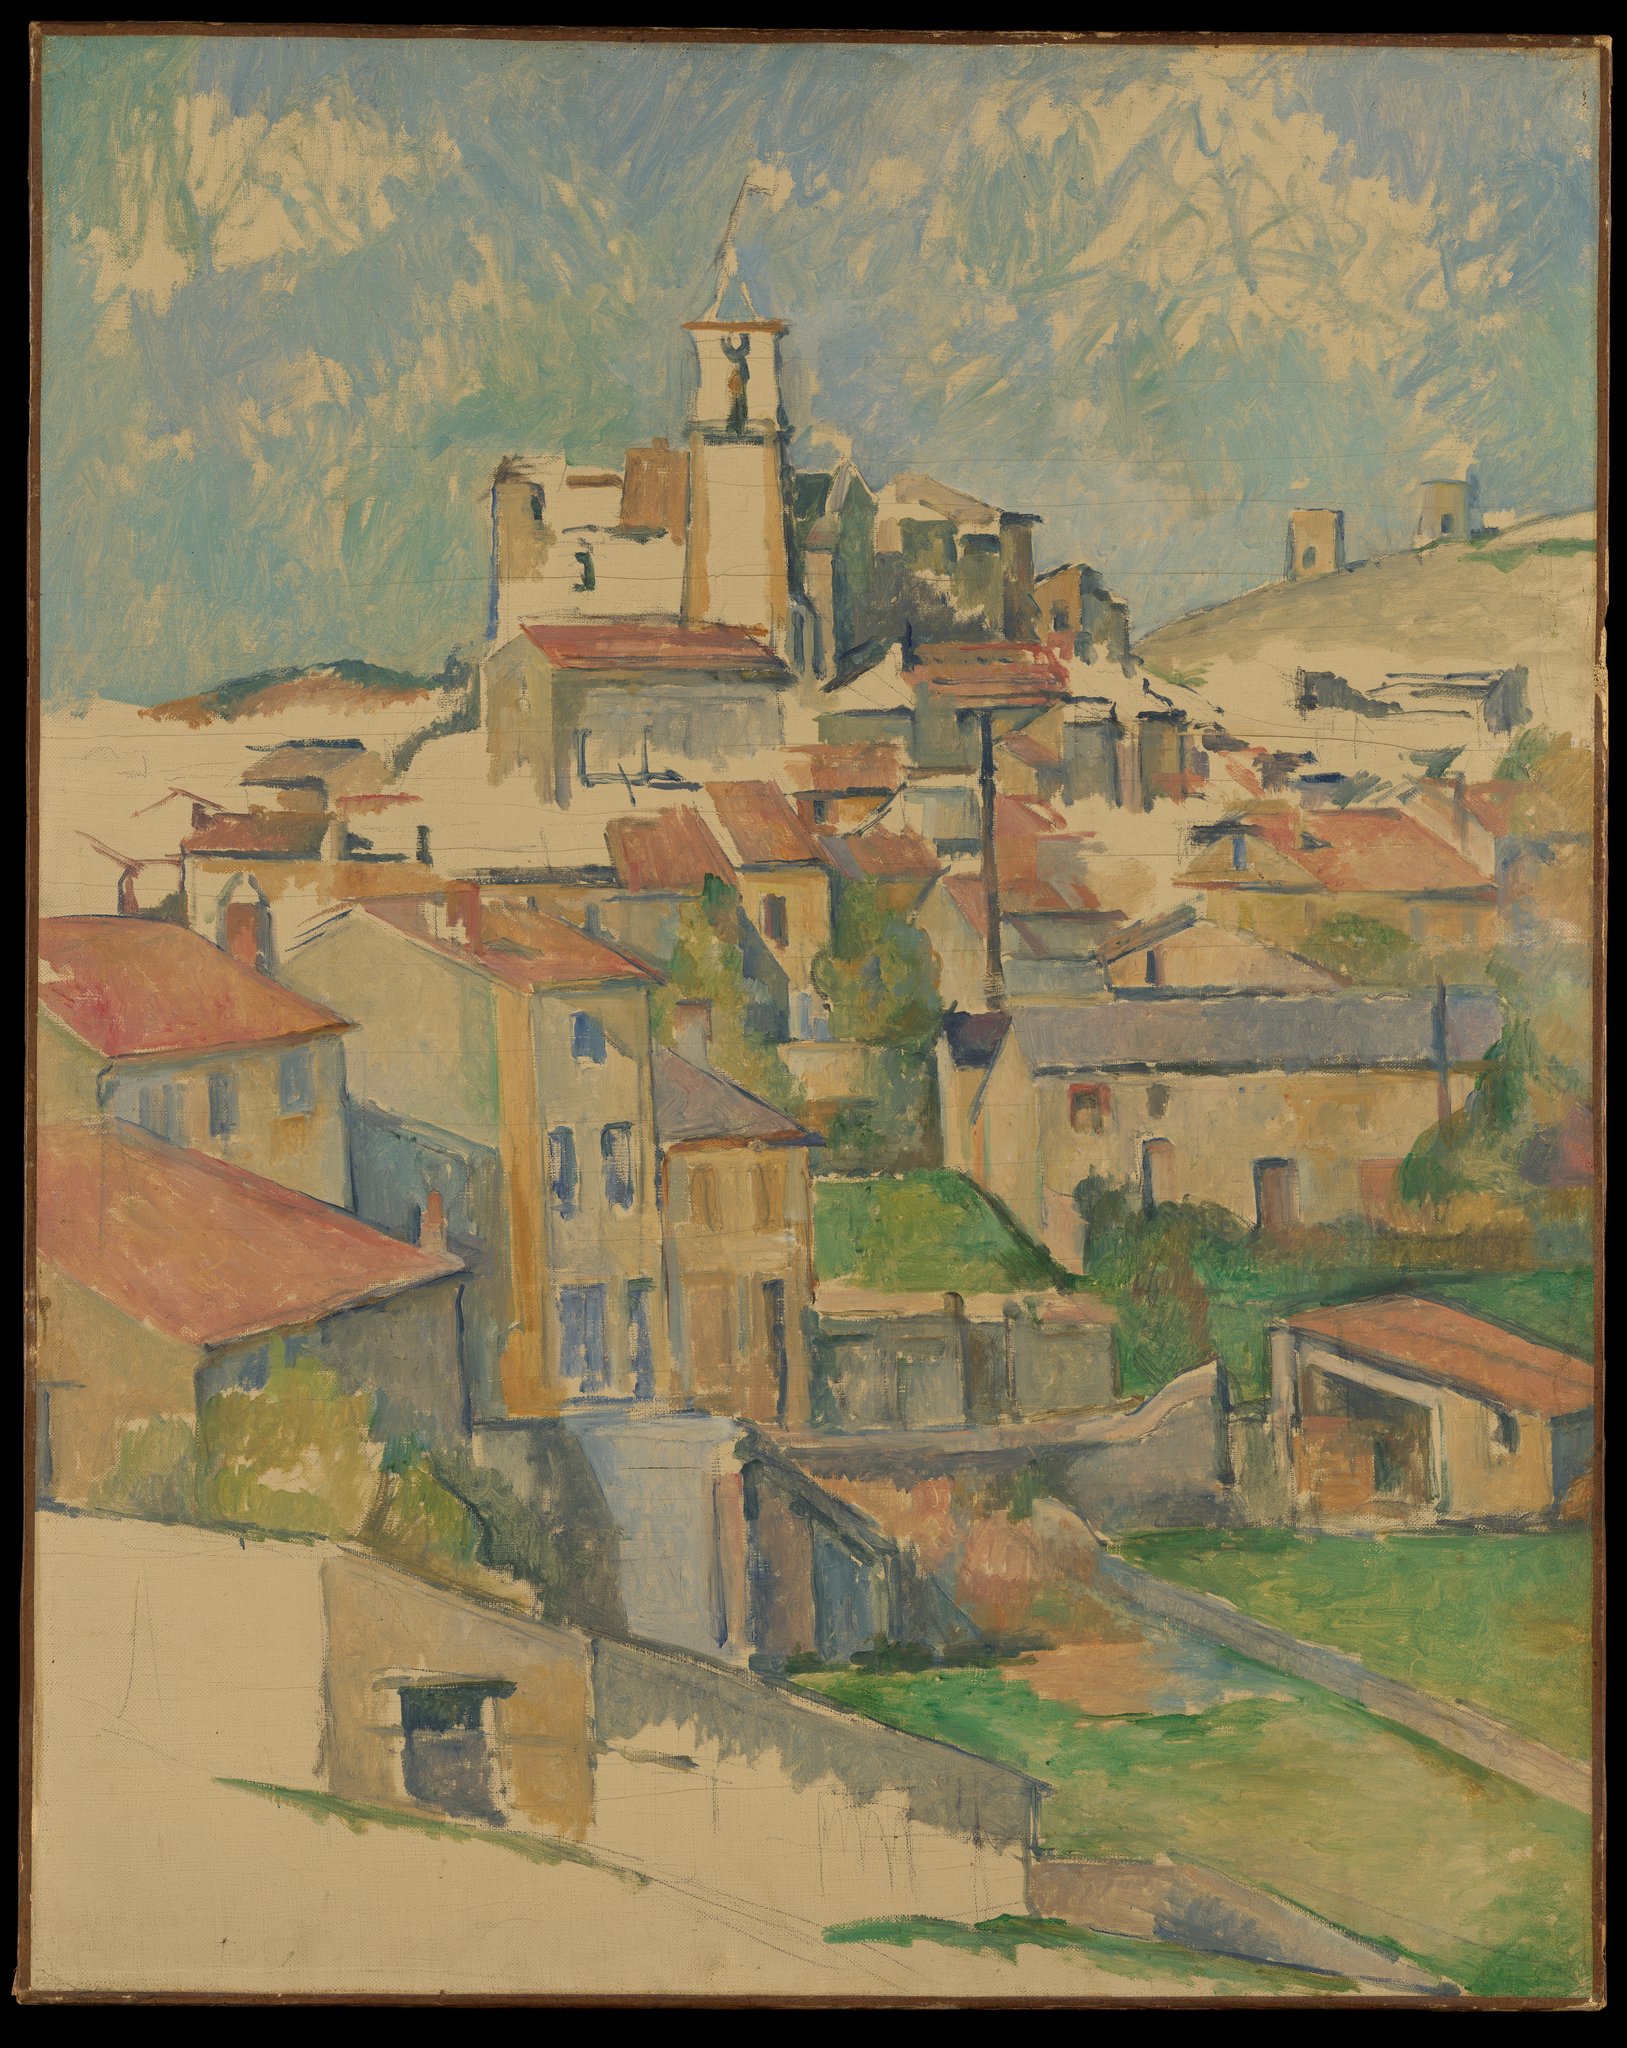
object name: painting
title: Gardanne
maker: paul cézanne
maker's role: artist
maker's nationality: french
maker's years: 1839-1906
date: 1885-1886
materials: canvas, oil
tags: buildings,towns